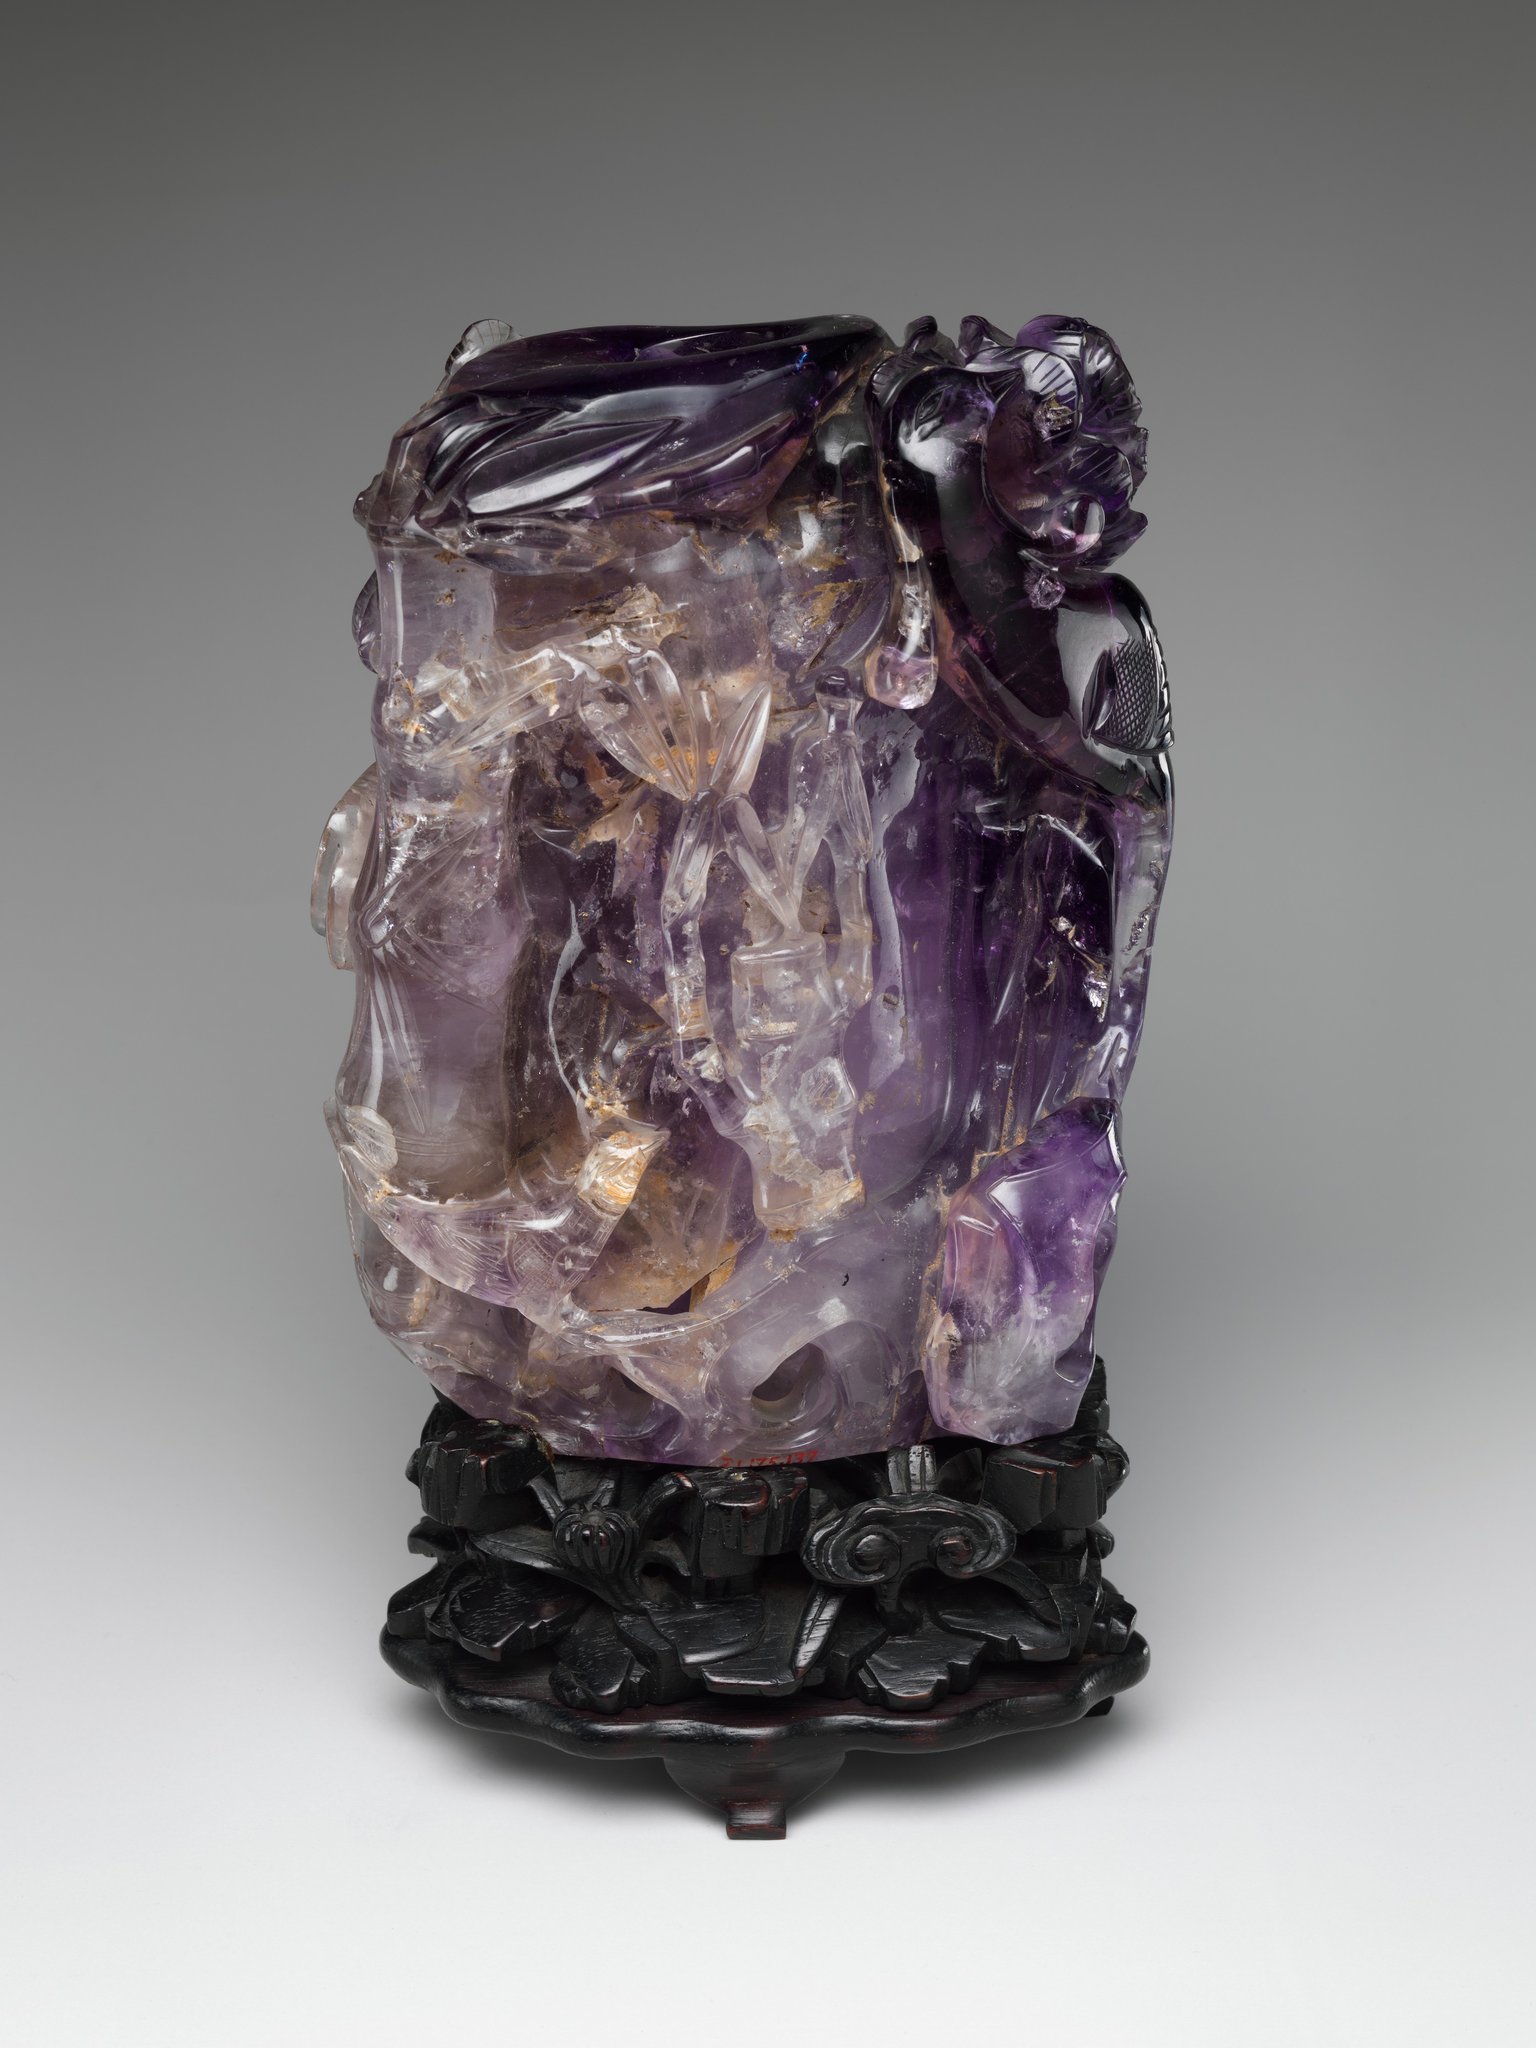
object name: vase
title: Vase with bird and flowers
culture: chinese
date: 1644-1911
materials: gemstone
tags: birds,flowers